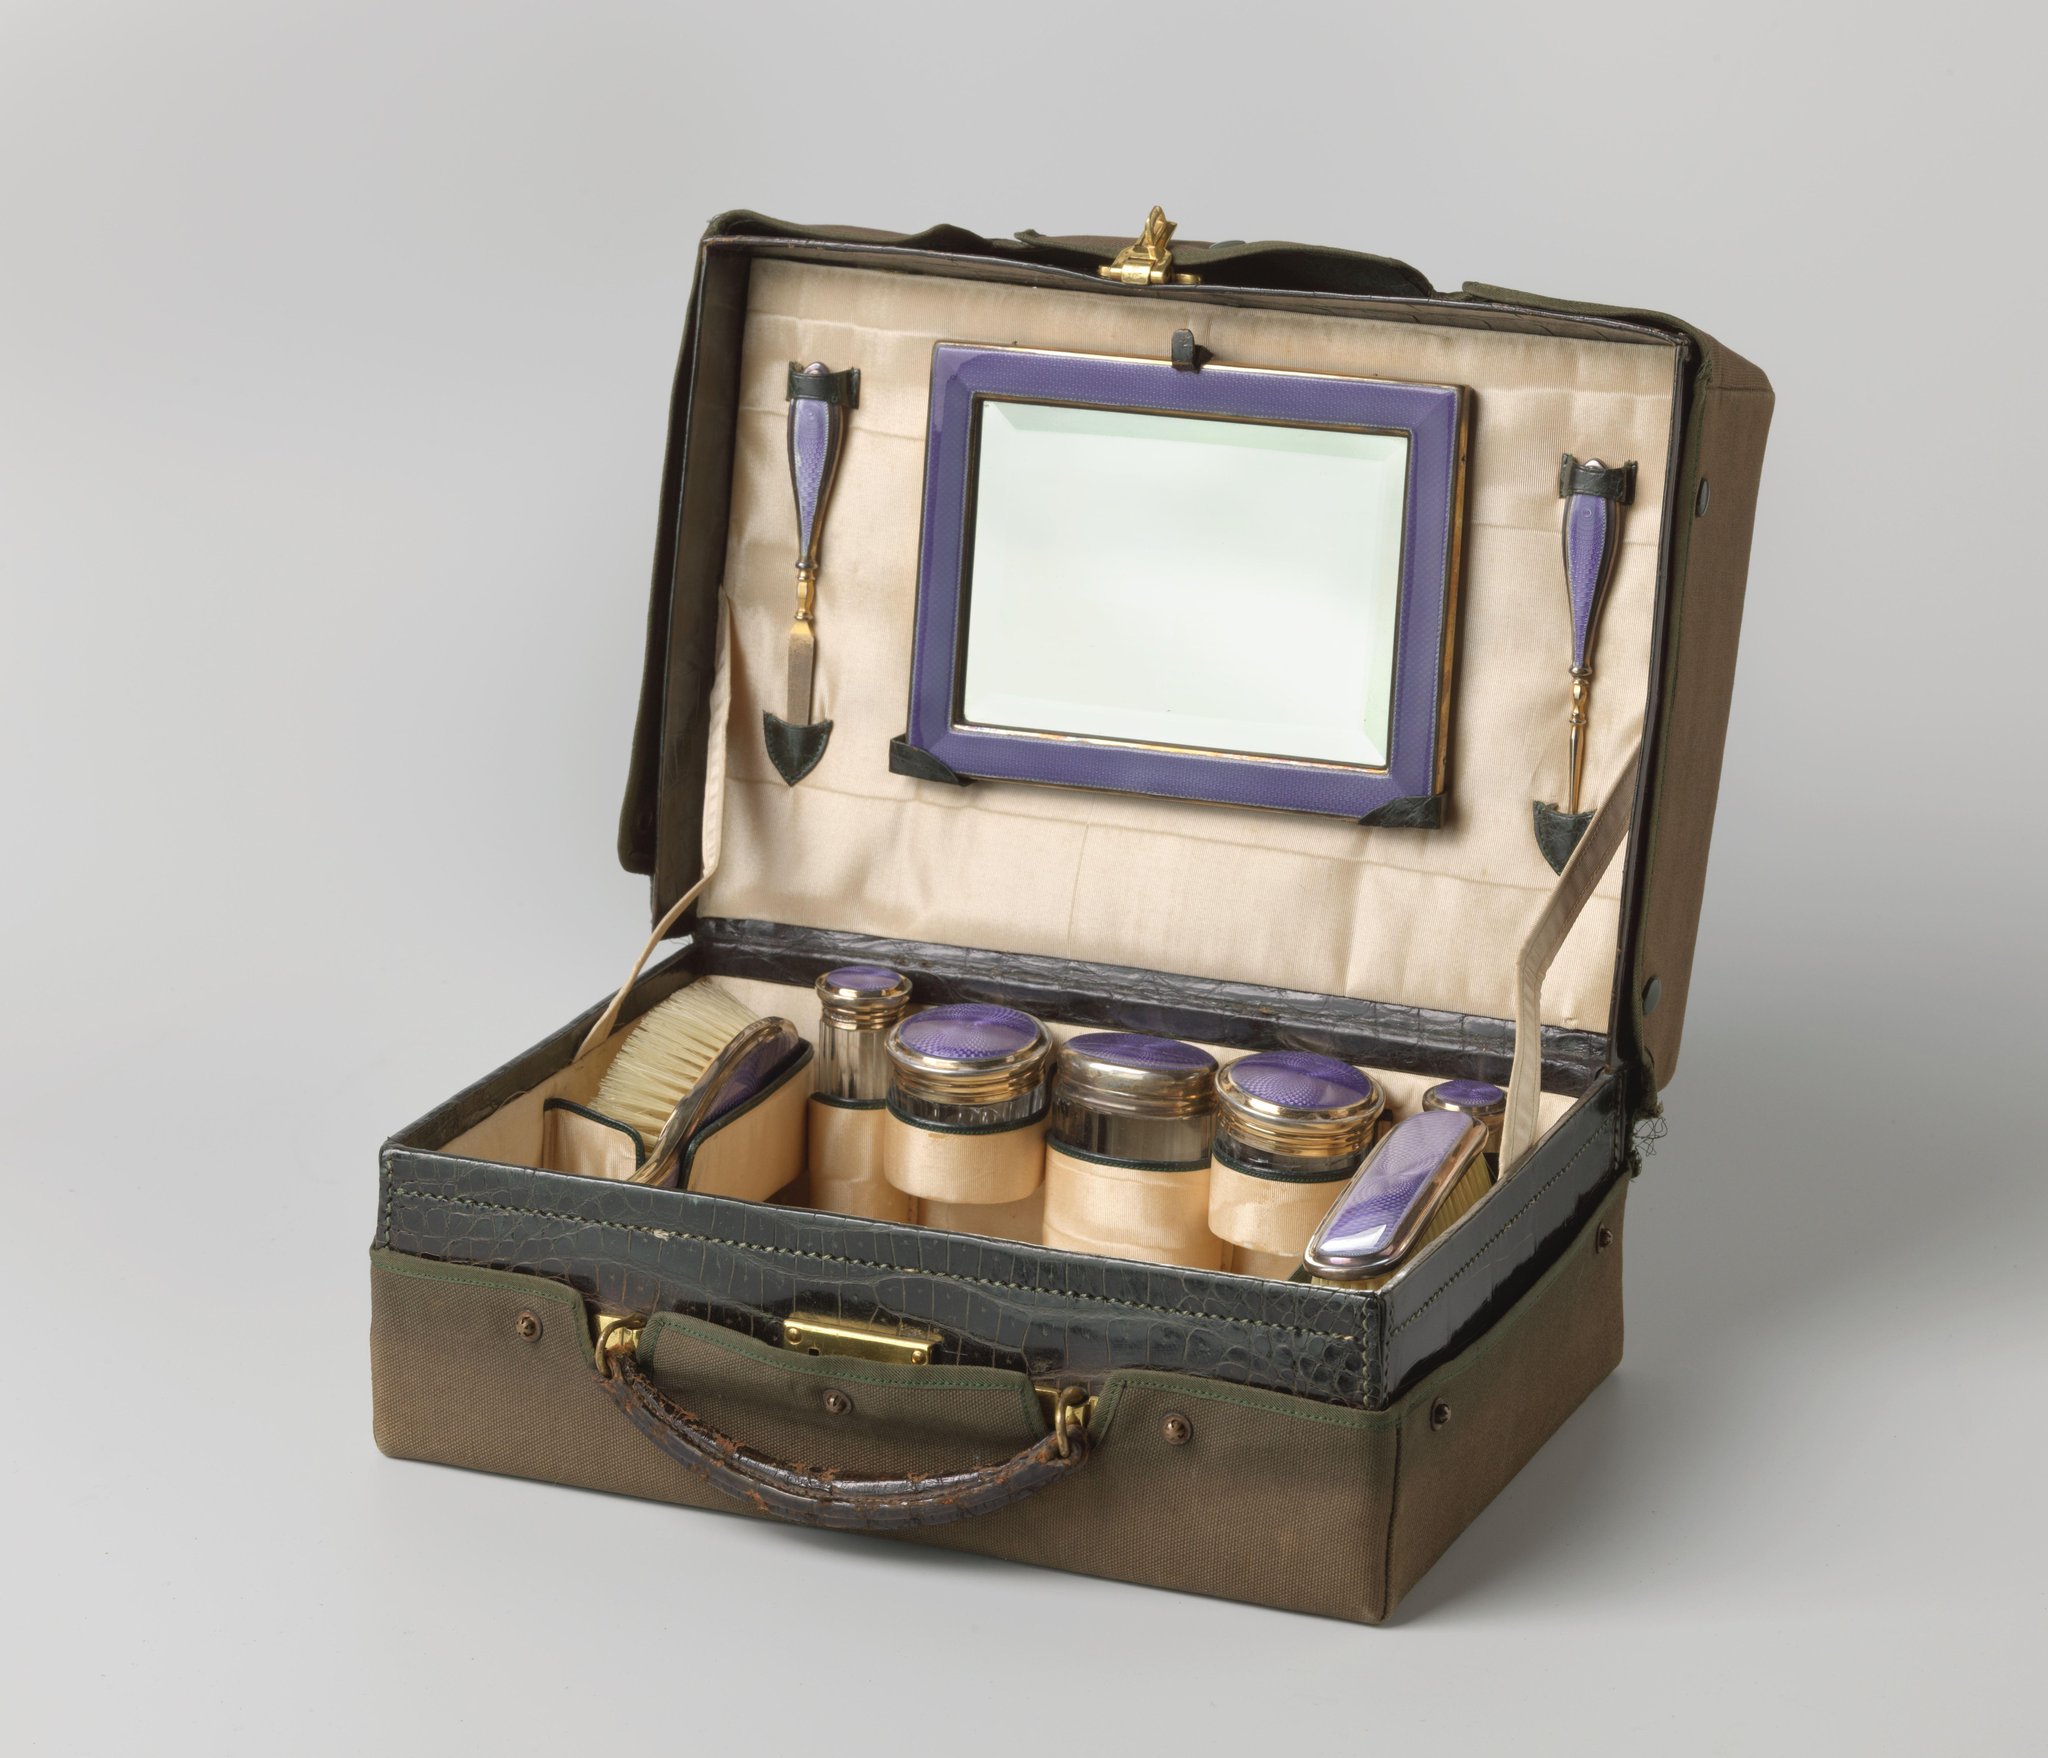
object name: reisnecessaire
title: Reisnecessaire met initialen J.M.S.S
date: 1924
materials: canvas, silk, silver, skin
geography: birmingham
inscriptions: assayer's mark: ‘Bimingham’, maker's mark: ‘A Bros’, date letter: ‘Z’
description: In de deksel zitten een spiegel en twee nagelgarnituren. De bekleding is van moire zijde. Op de deksel zijn initialen J.M.S.S. Het geheel is verpakt in een foul weather cover, eveneens voorzien van initialen. Twee sleutels aanwezig. Inhoud: kledingborstel, borstel, kam, twee ronde flacons, ovale flacon, cilinder flacon, rechthoekige flacon, tandenborstel flacon, alle met geguillocheerde paarse emaille deksels en vergulde randen.